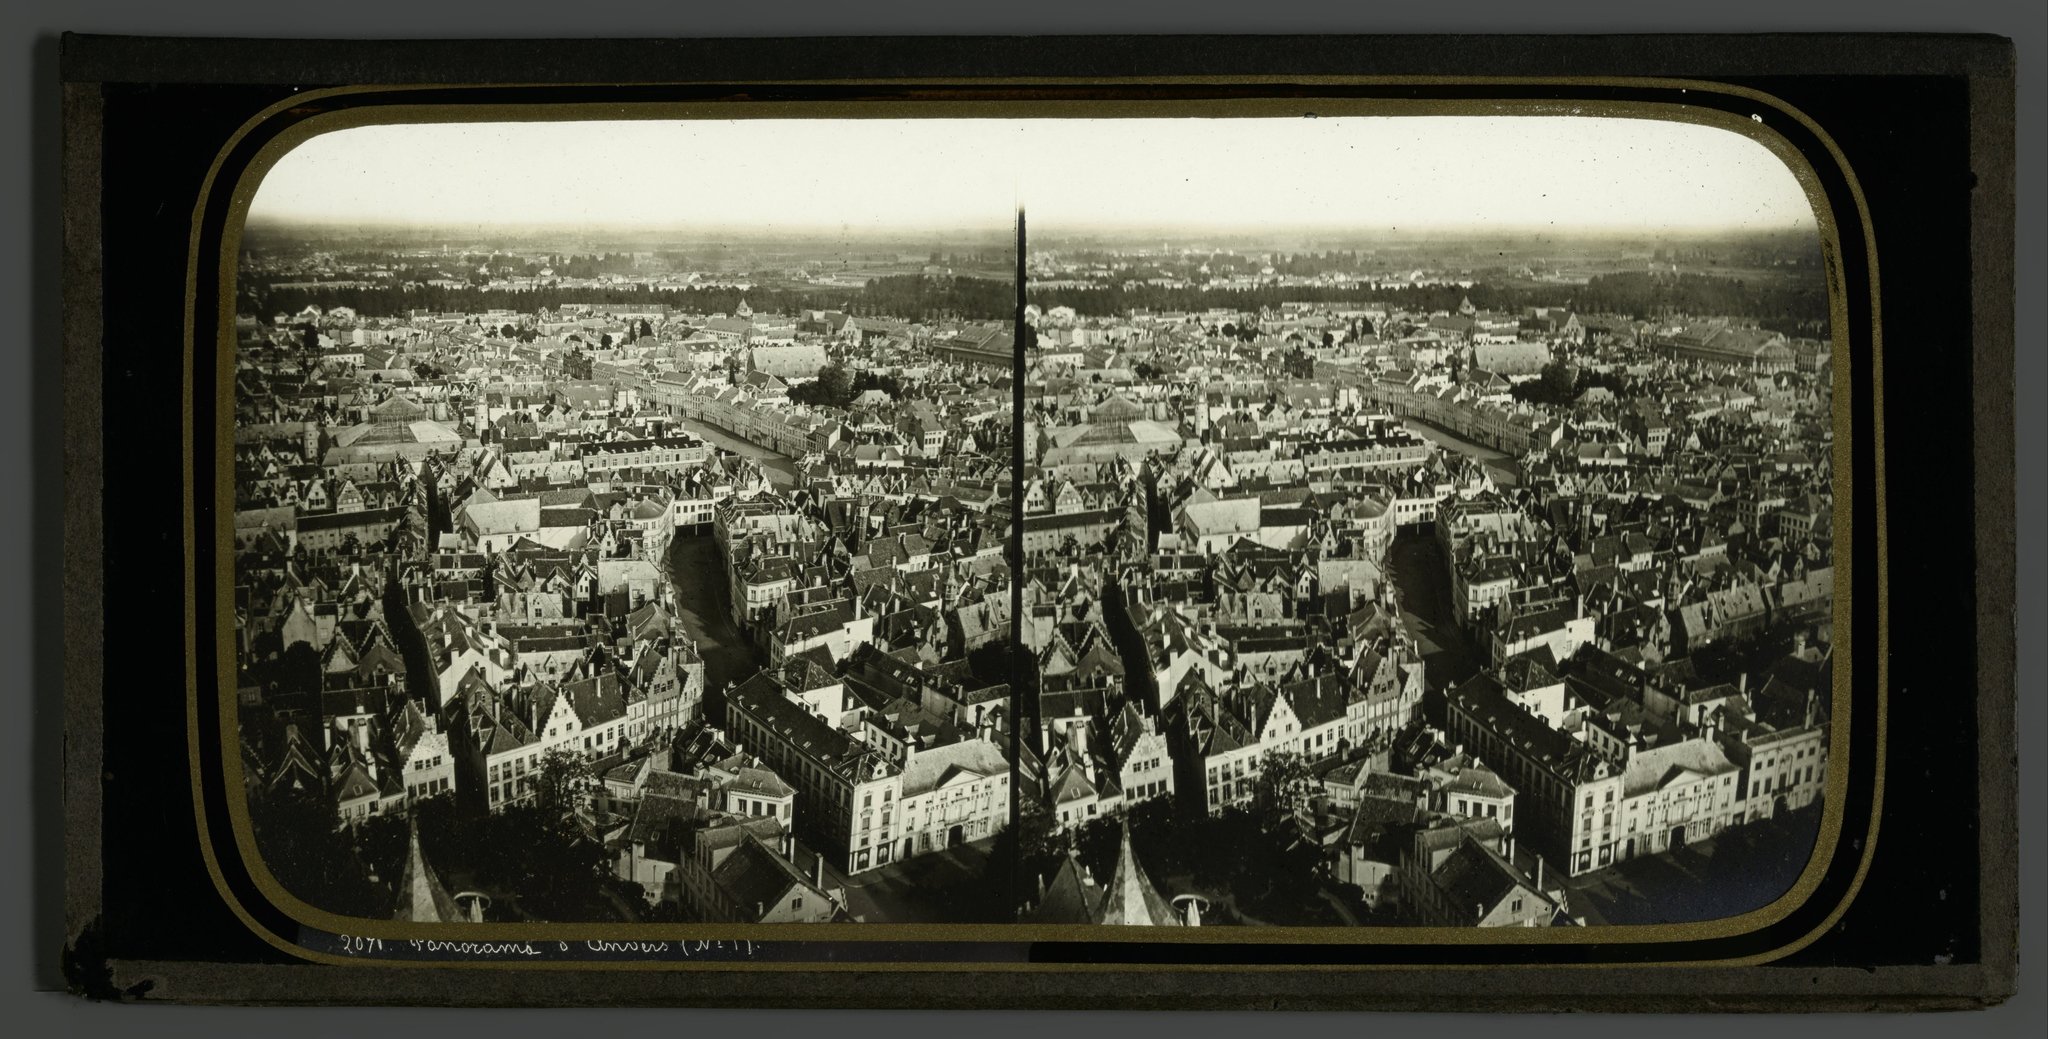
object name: photograph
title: Gezicht op Antwerpen vanaf de Onze-Lieve-Vrouwekathedraal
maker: Anonymous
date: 1852-1854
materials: glass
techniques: slide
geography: antwerp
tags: city-view in general; 'veduta', antwerp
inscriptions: number: ‘2071.’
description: Gezicht op Antwerpen vanaf de Onze-Lieve-Vrouwekathedraal. Op de achtergrond, tegen het Stadspark, is de Huidevetterstoren zichtbaar.